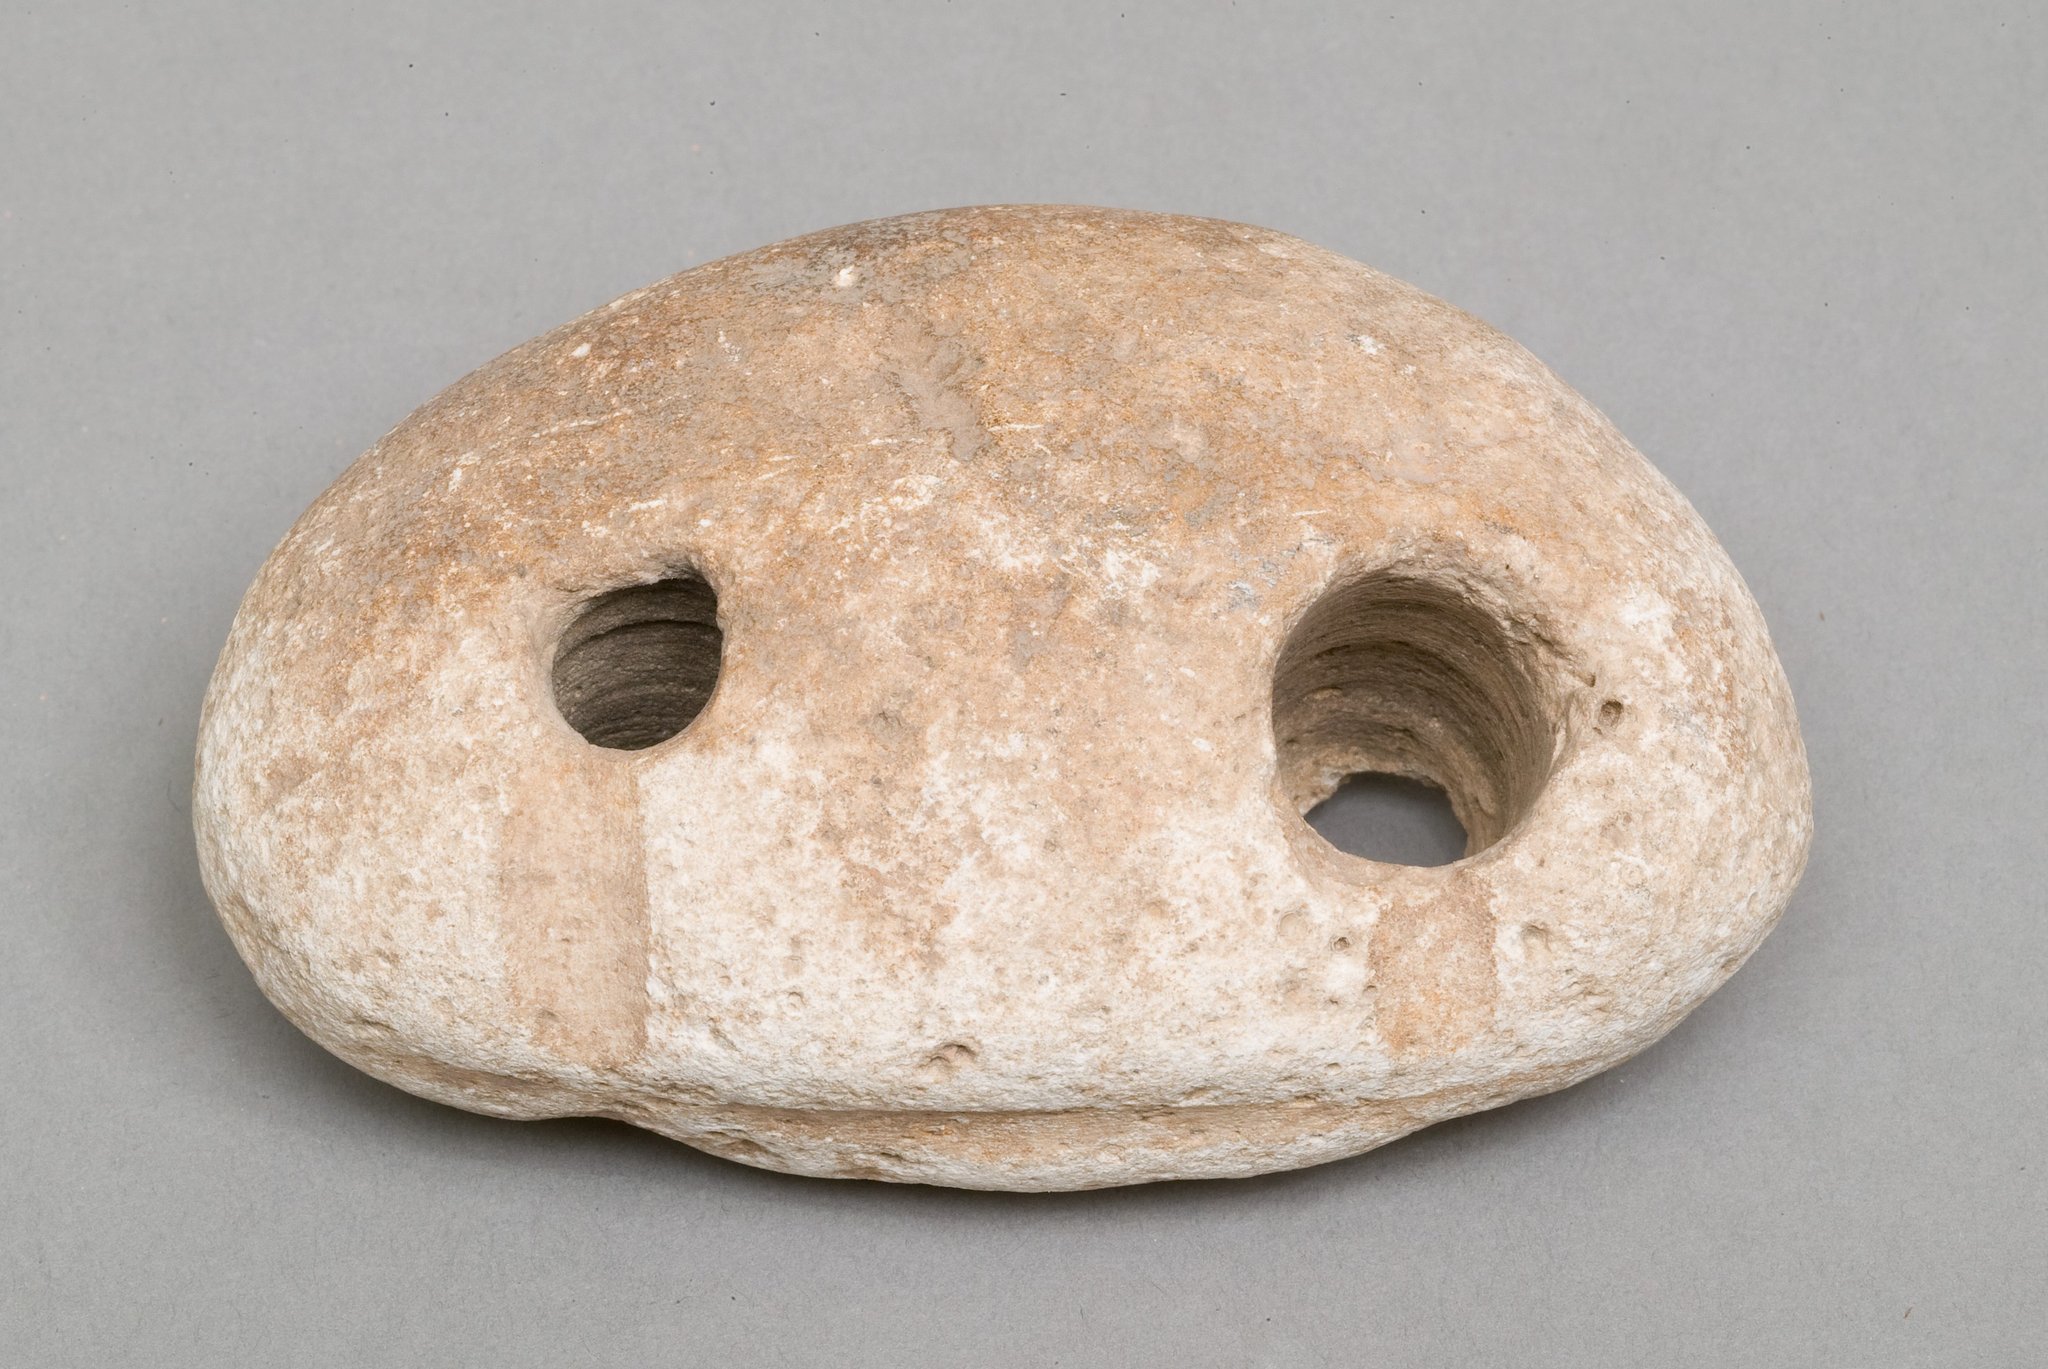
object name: weighing down device fish net sinker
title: Weighing down device (fish net sinker?)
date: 1295-1070 BCE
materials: limestone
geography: egypt